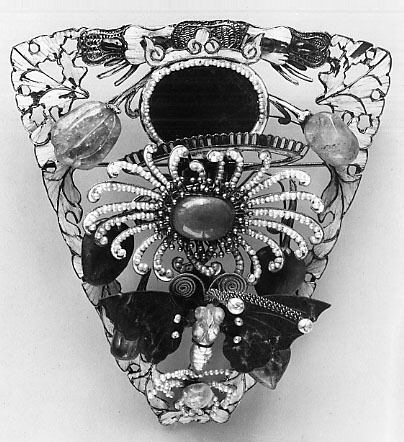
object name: ornament for manzhu hat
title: Ornaments for Manzhu Hat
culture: chinese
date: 1701-1800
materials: coral, feather, glass, jade, metal, pearl, gemstone